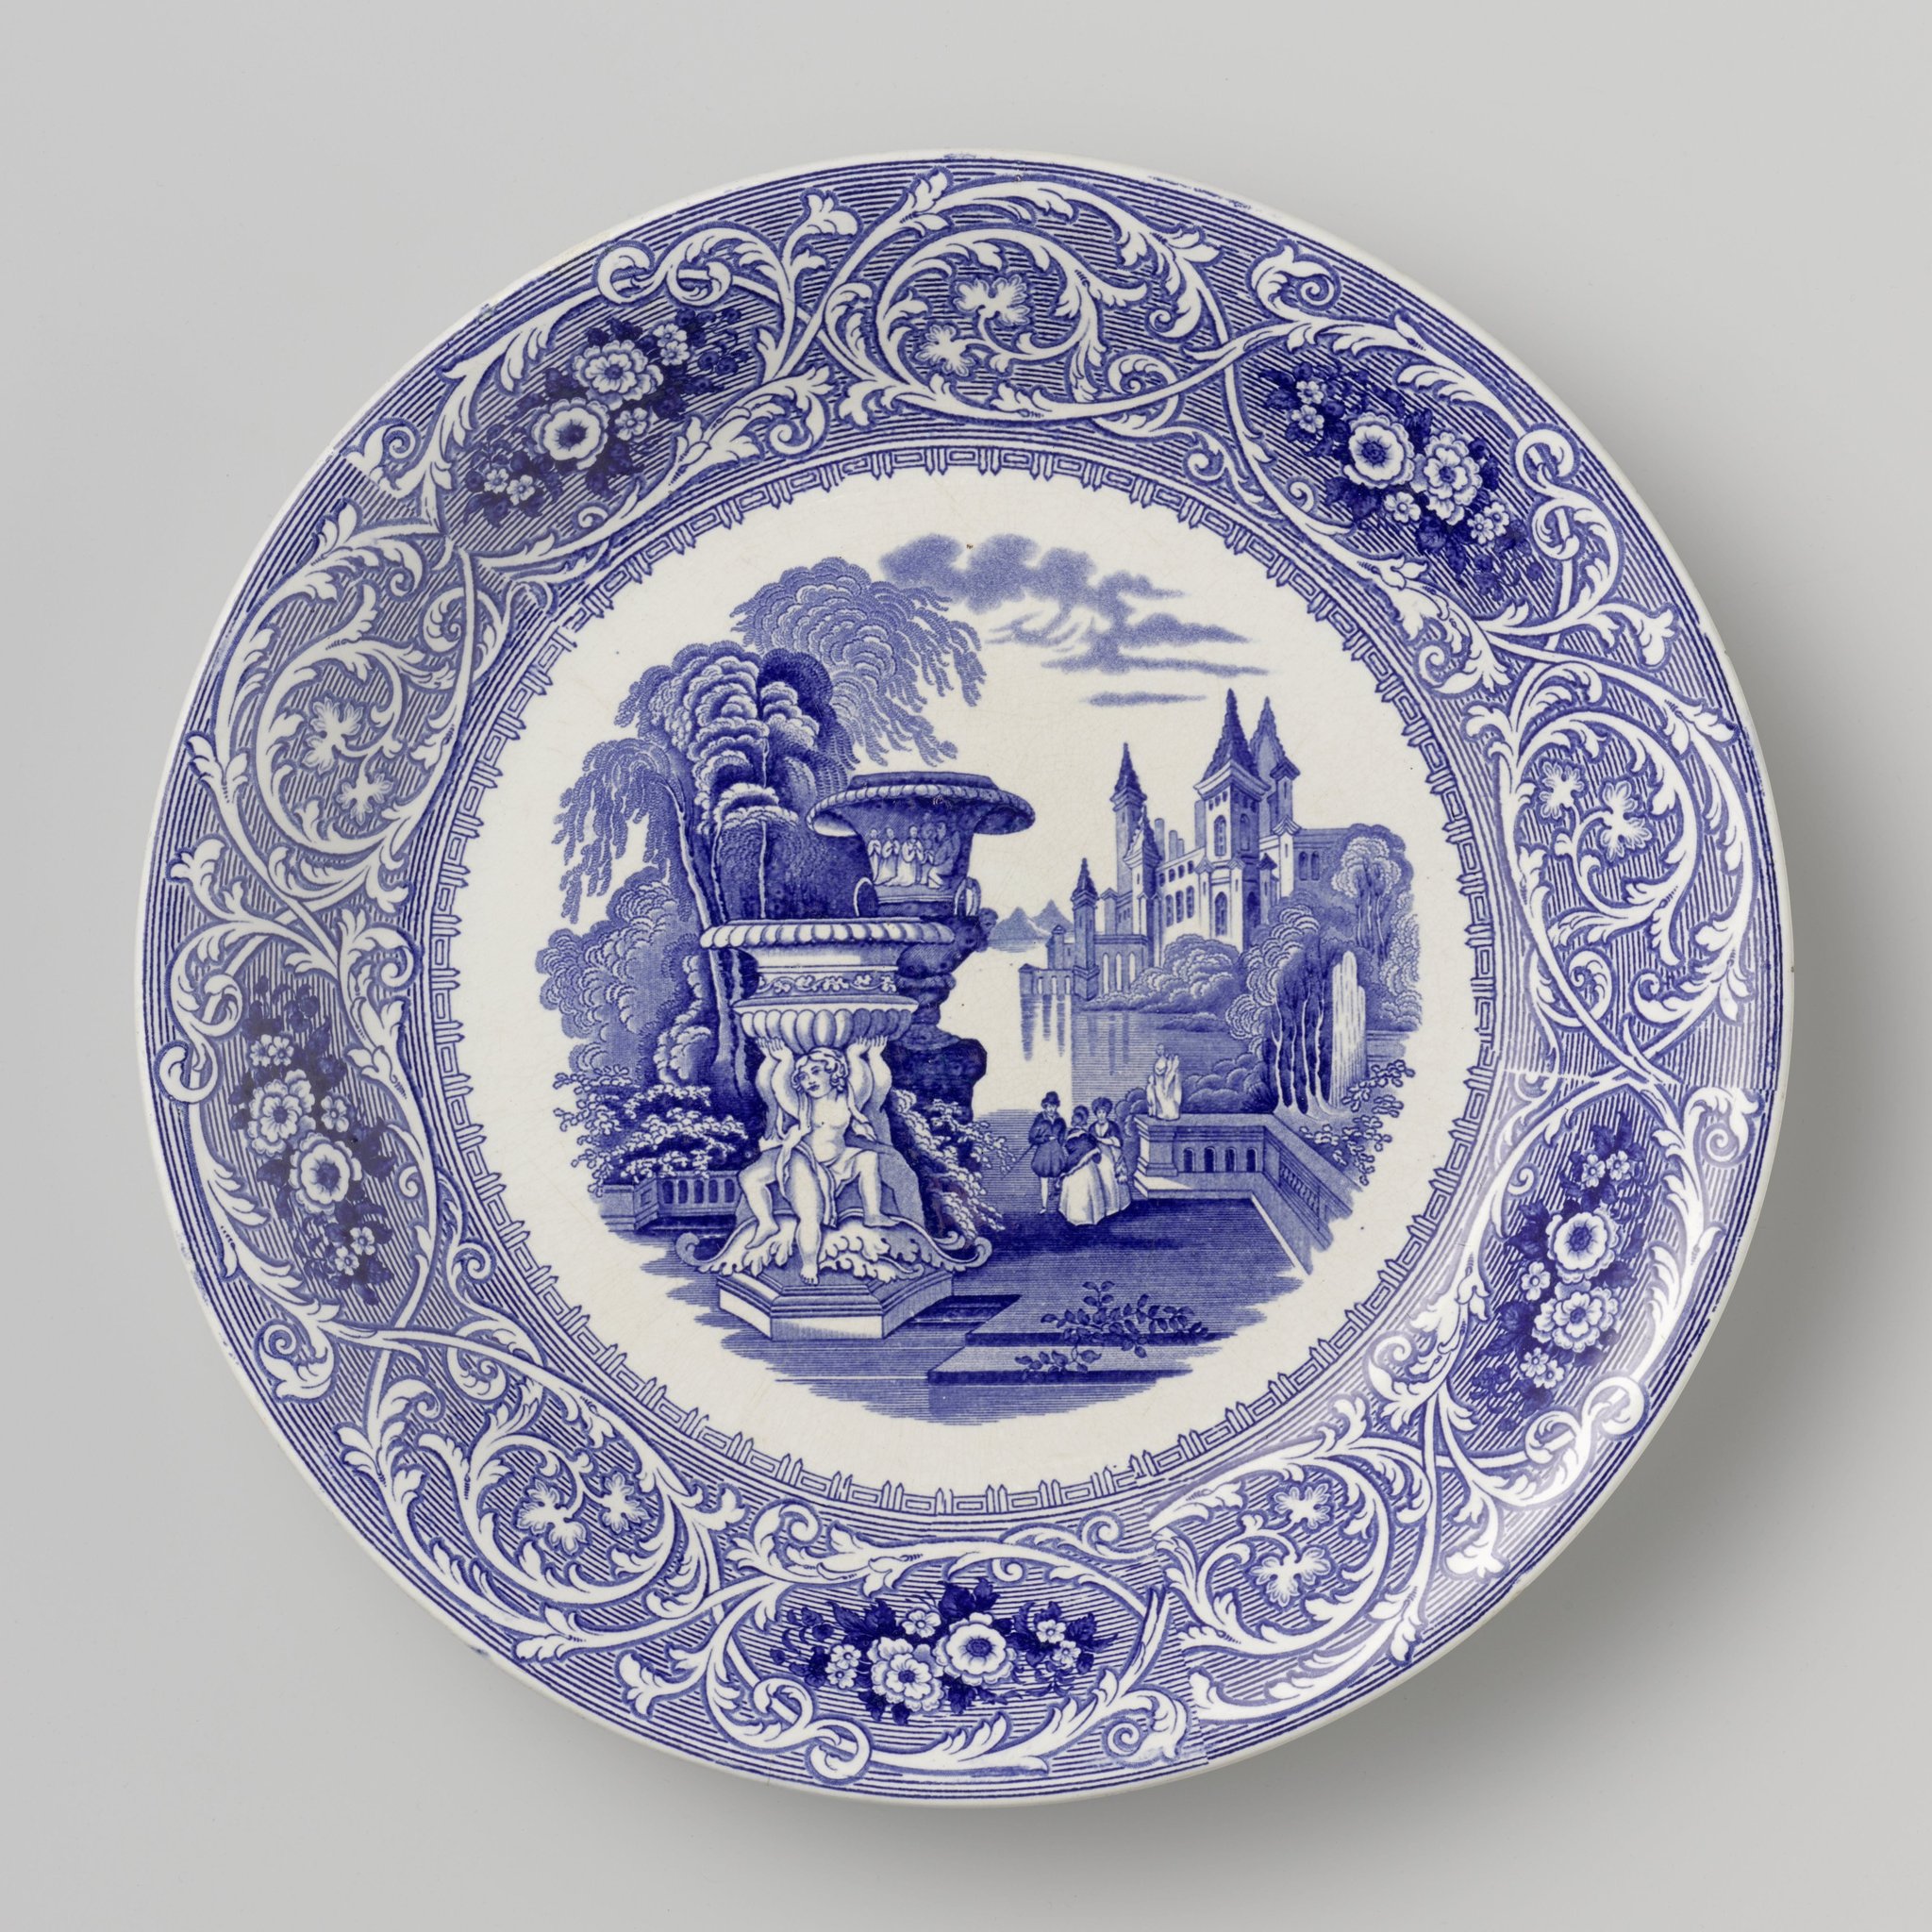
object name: platter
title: Schotel met op het plat een wandelend gezelschap in een tuin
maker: petrus regout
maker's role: plateelbakker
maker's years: 1801-1879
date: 1801-1879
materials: earthenware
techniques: transfer decoration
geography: maastricht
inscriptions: mark: ‘PR // PALMIRE 10’, check stamp: ‘P. REGOUT // 15 // MAASTRICHT 11’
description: Schotel van aardewerk met vloeiblauw transferdecor. Op het plat een man en twee vrouwen wandelend in een tuin. Op de voorgrond twee tuinvazen. Op de achtergrond een kasteel aan een meer of vijver. De rand van de schotel met in elkaar gevlochten bladranken en bloemboeketten tegen een gestreepte achtergrond.